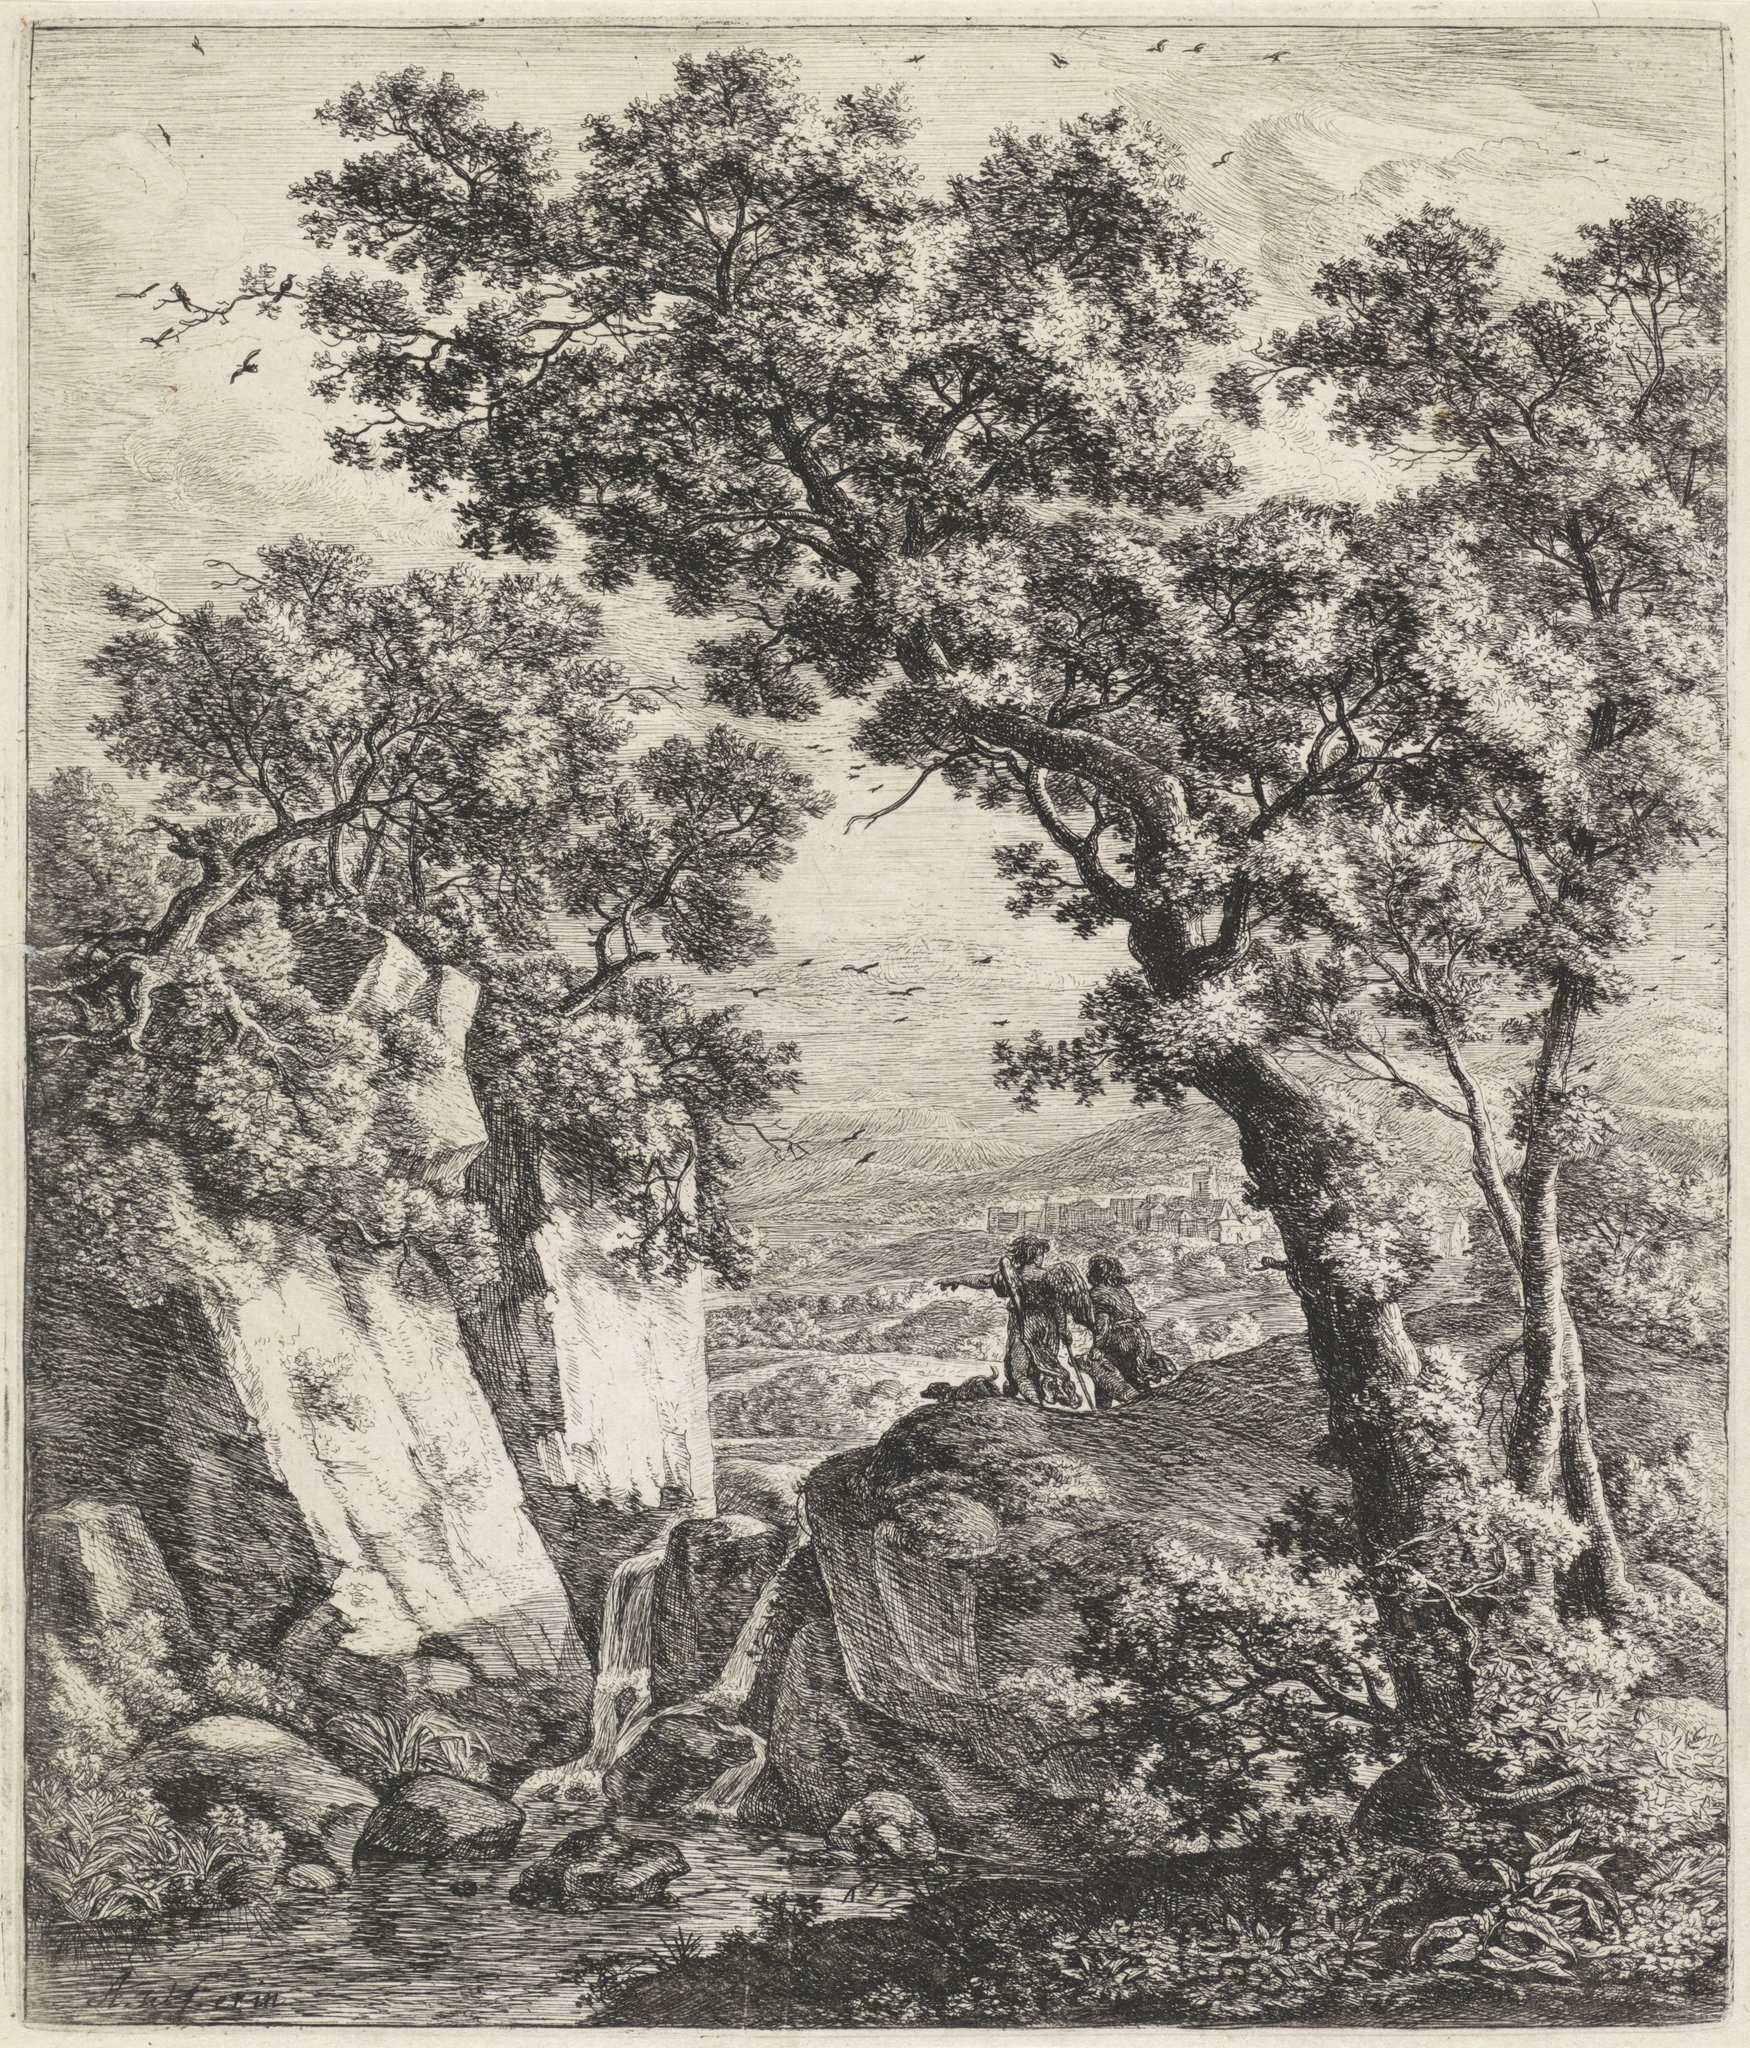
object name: print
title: Landschappen met Bijbelse voorstellingen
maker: anthonie waterloo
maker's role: draughtsman, painter, print maker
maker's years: 1609-1690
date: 1630-1663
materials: paper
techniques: etching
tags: tobias and the angel raphael travelling, accompanied by tobias' dog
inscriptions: collector's mark: Lugt 240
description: Tobias en zijn hond lopen met de aartsengel Rafaël over een bospad in de richting van een hoge rotswand. Voor de rotswand stroomt een rivier met een waterval. Rafaël wijst ernaar. In de verte ligt een stad aan de voet van een berg.